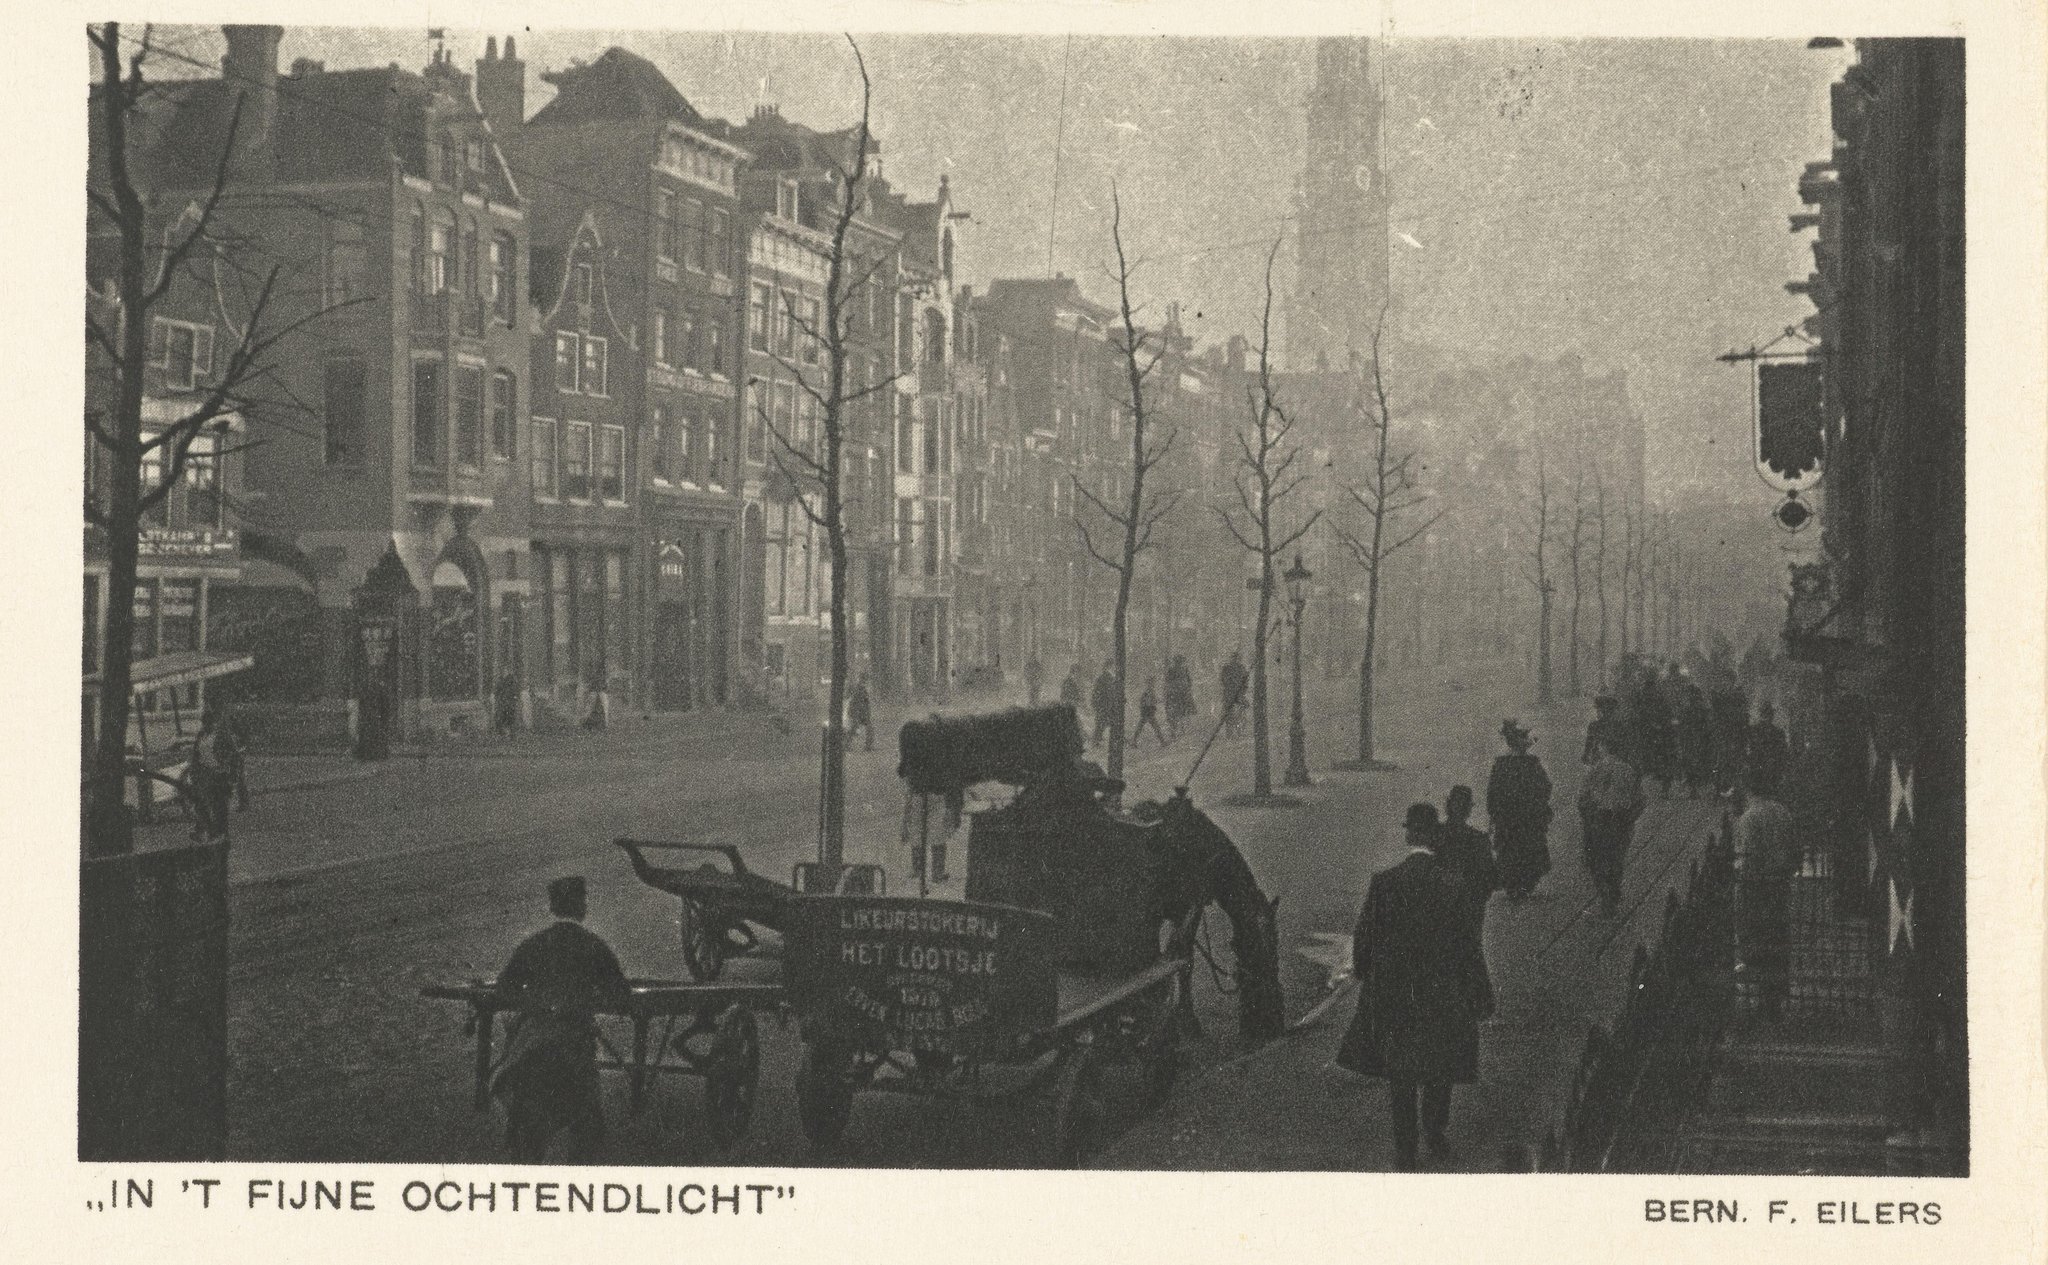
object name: photograph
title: Gezicht op de Rozengracht, Amsterdam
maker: bernard eilers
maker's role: fotograaf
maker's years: 1878-1951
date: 1913-1940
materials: paper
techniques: rotogravure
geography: amsterdam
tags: urban housing, parts of church exterior and annexes: tower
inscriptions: signature and date: ‘Bern. F. Eilers; verso gedrukt: Eilers' Artistieke Kaarten - Uitg.-Mij. "Kosmos" - Amsterdam.’, inscription: ‘"In 't fijne ochtendlicht"; verso linksboven gedrukt:Serie B / Amsterdam - Rozengracht.’